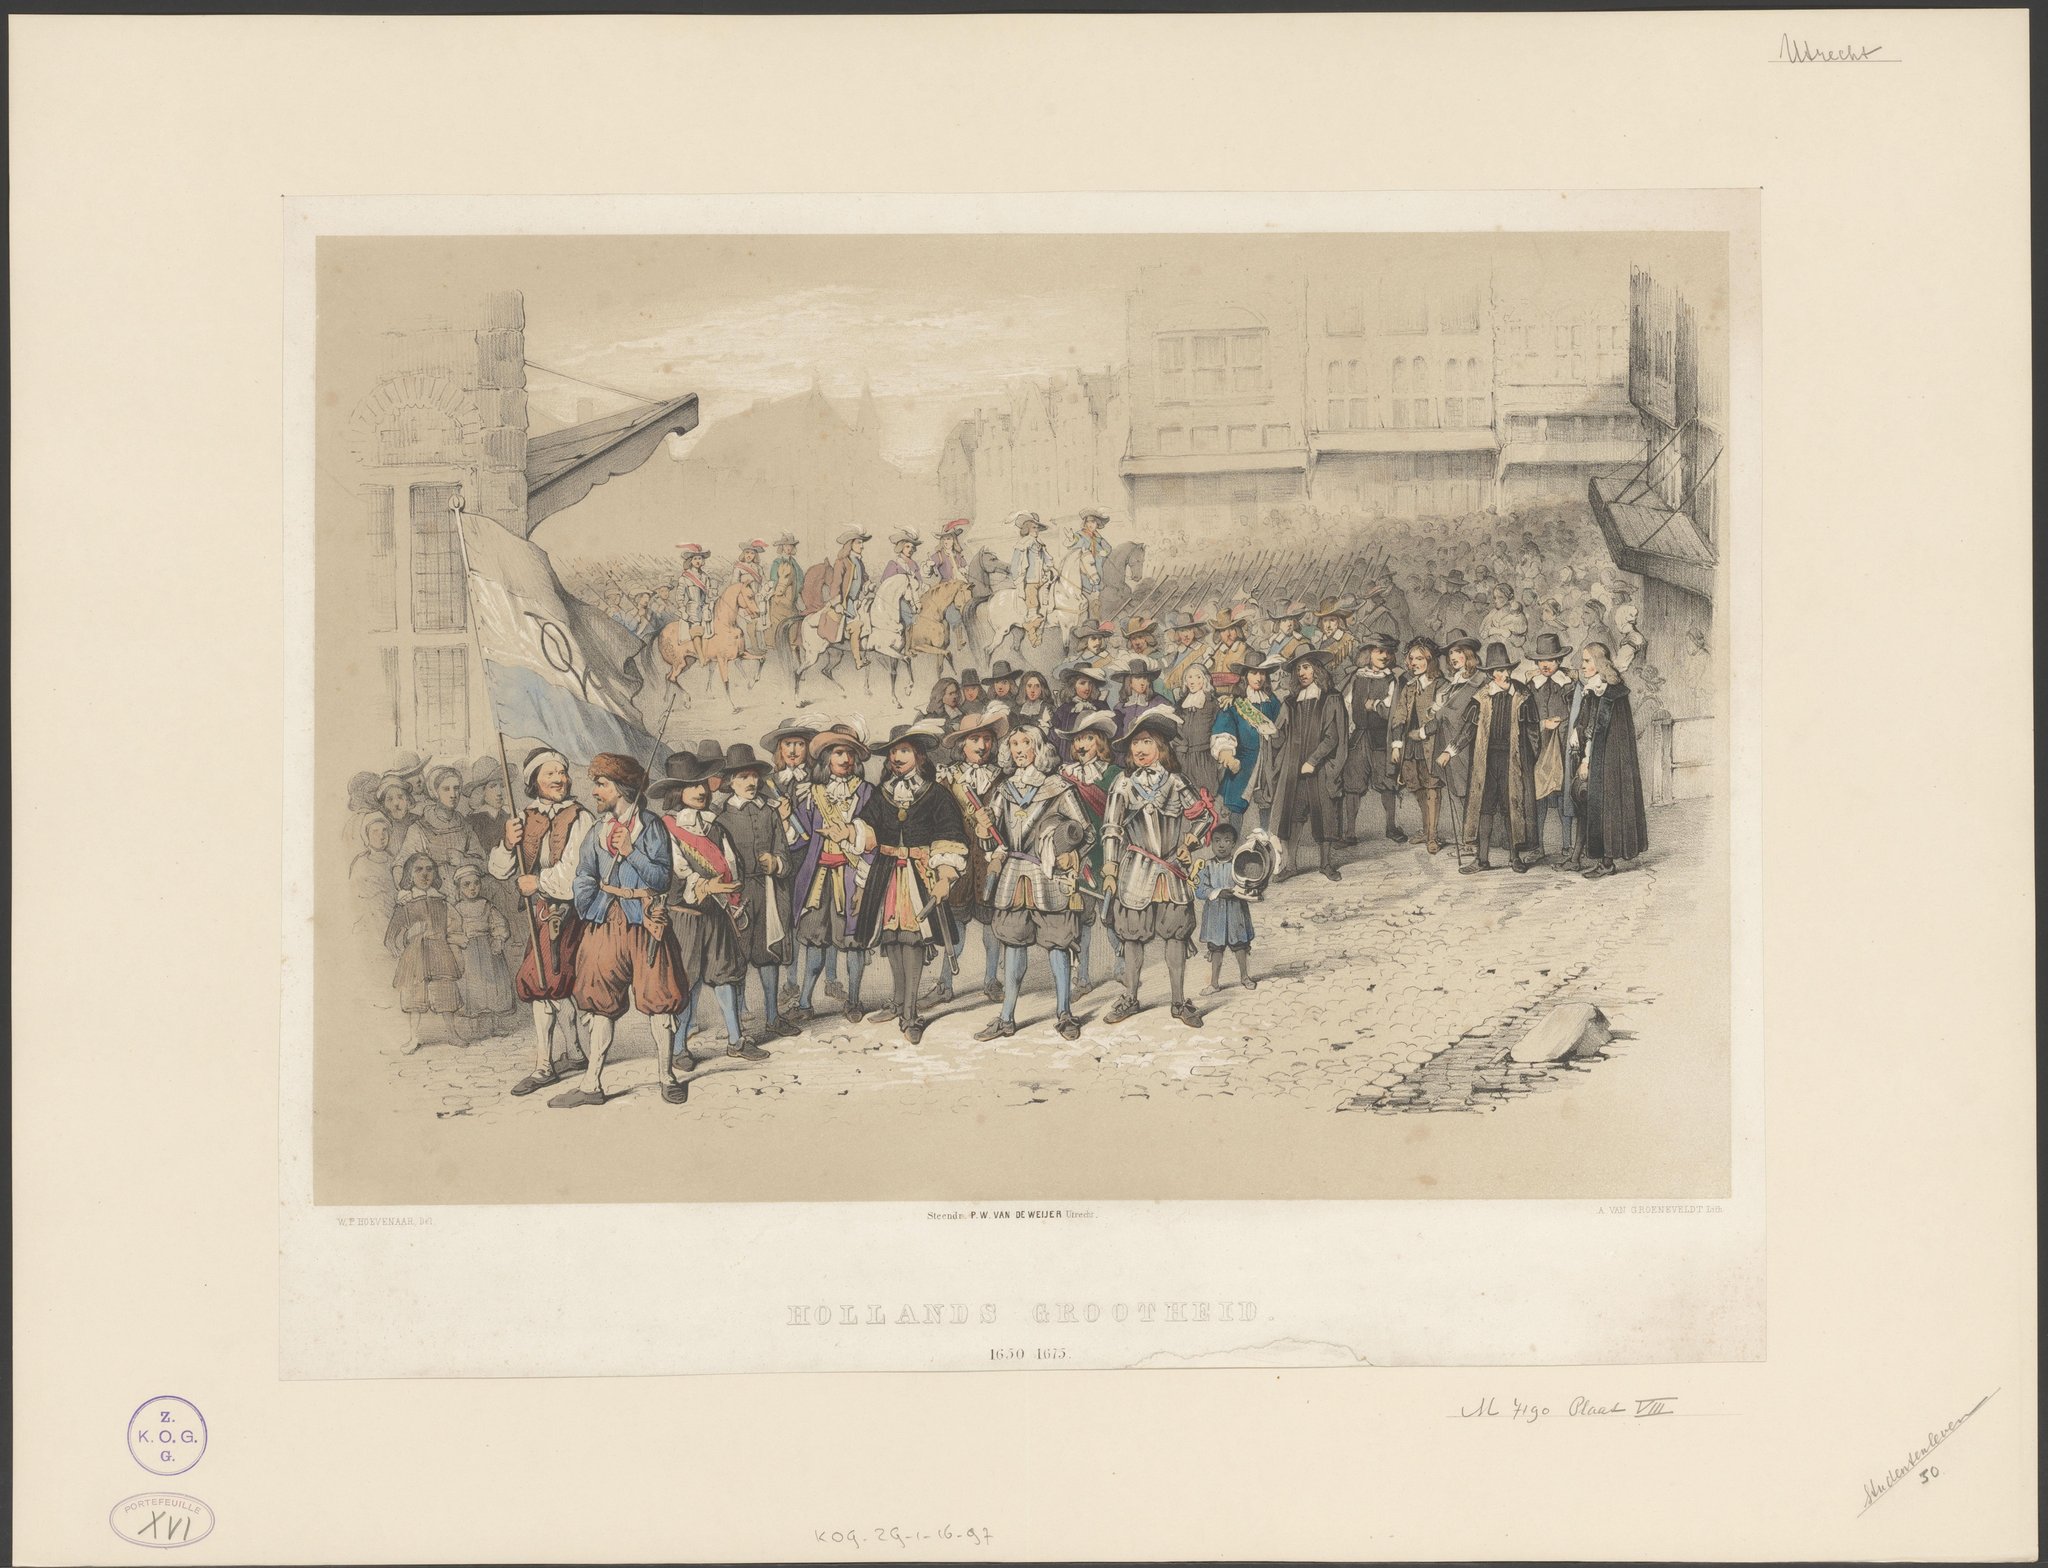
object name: print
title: Utrechtse maskerade van 1851: Gouden Eeuw 1650-1675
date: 1851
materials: paper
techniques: hand coloring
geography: utrecht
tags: students' pageant, costumes used in pageants, utrecht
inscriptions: stamp, collector's mark: Lugt 1641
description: Prent uit een serie van acht prenten en acht zangen van de maskerade van de Utrechtse studenten, 25 juni 1851. De maskerade verbeeldt in taferelen acht episodes uit de vaderlandse geschiedenis.